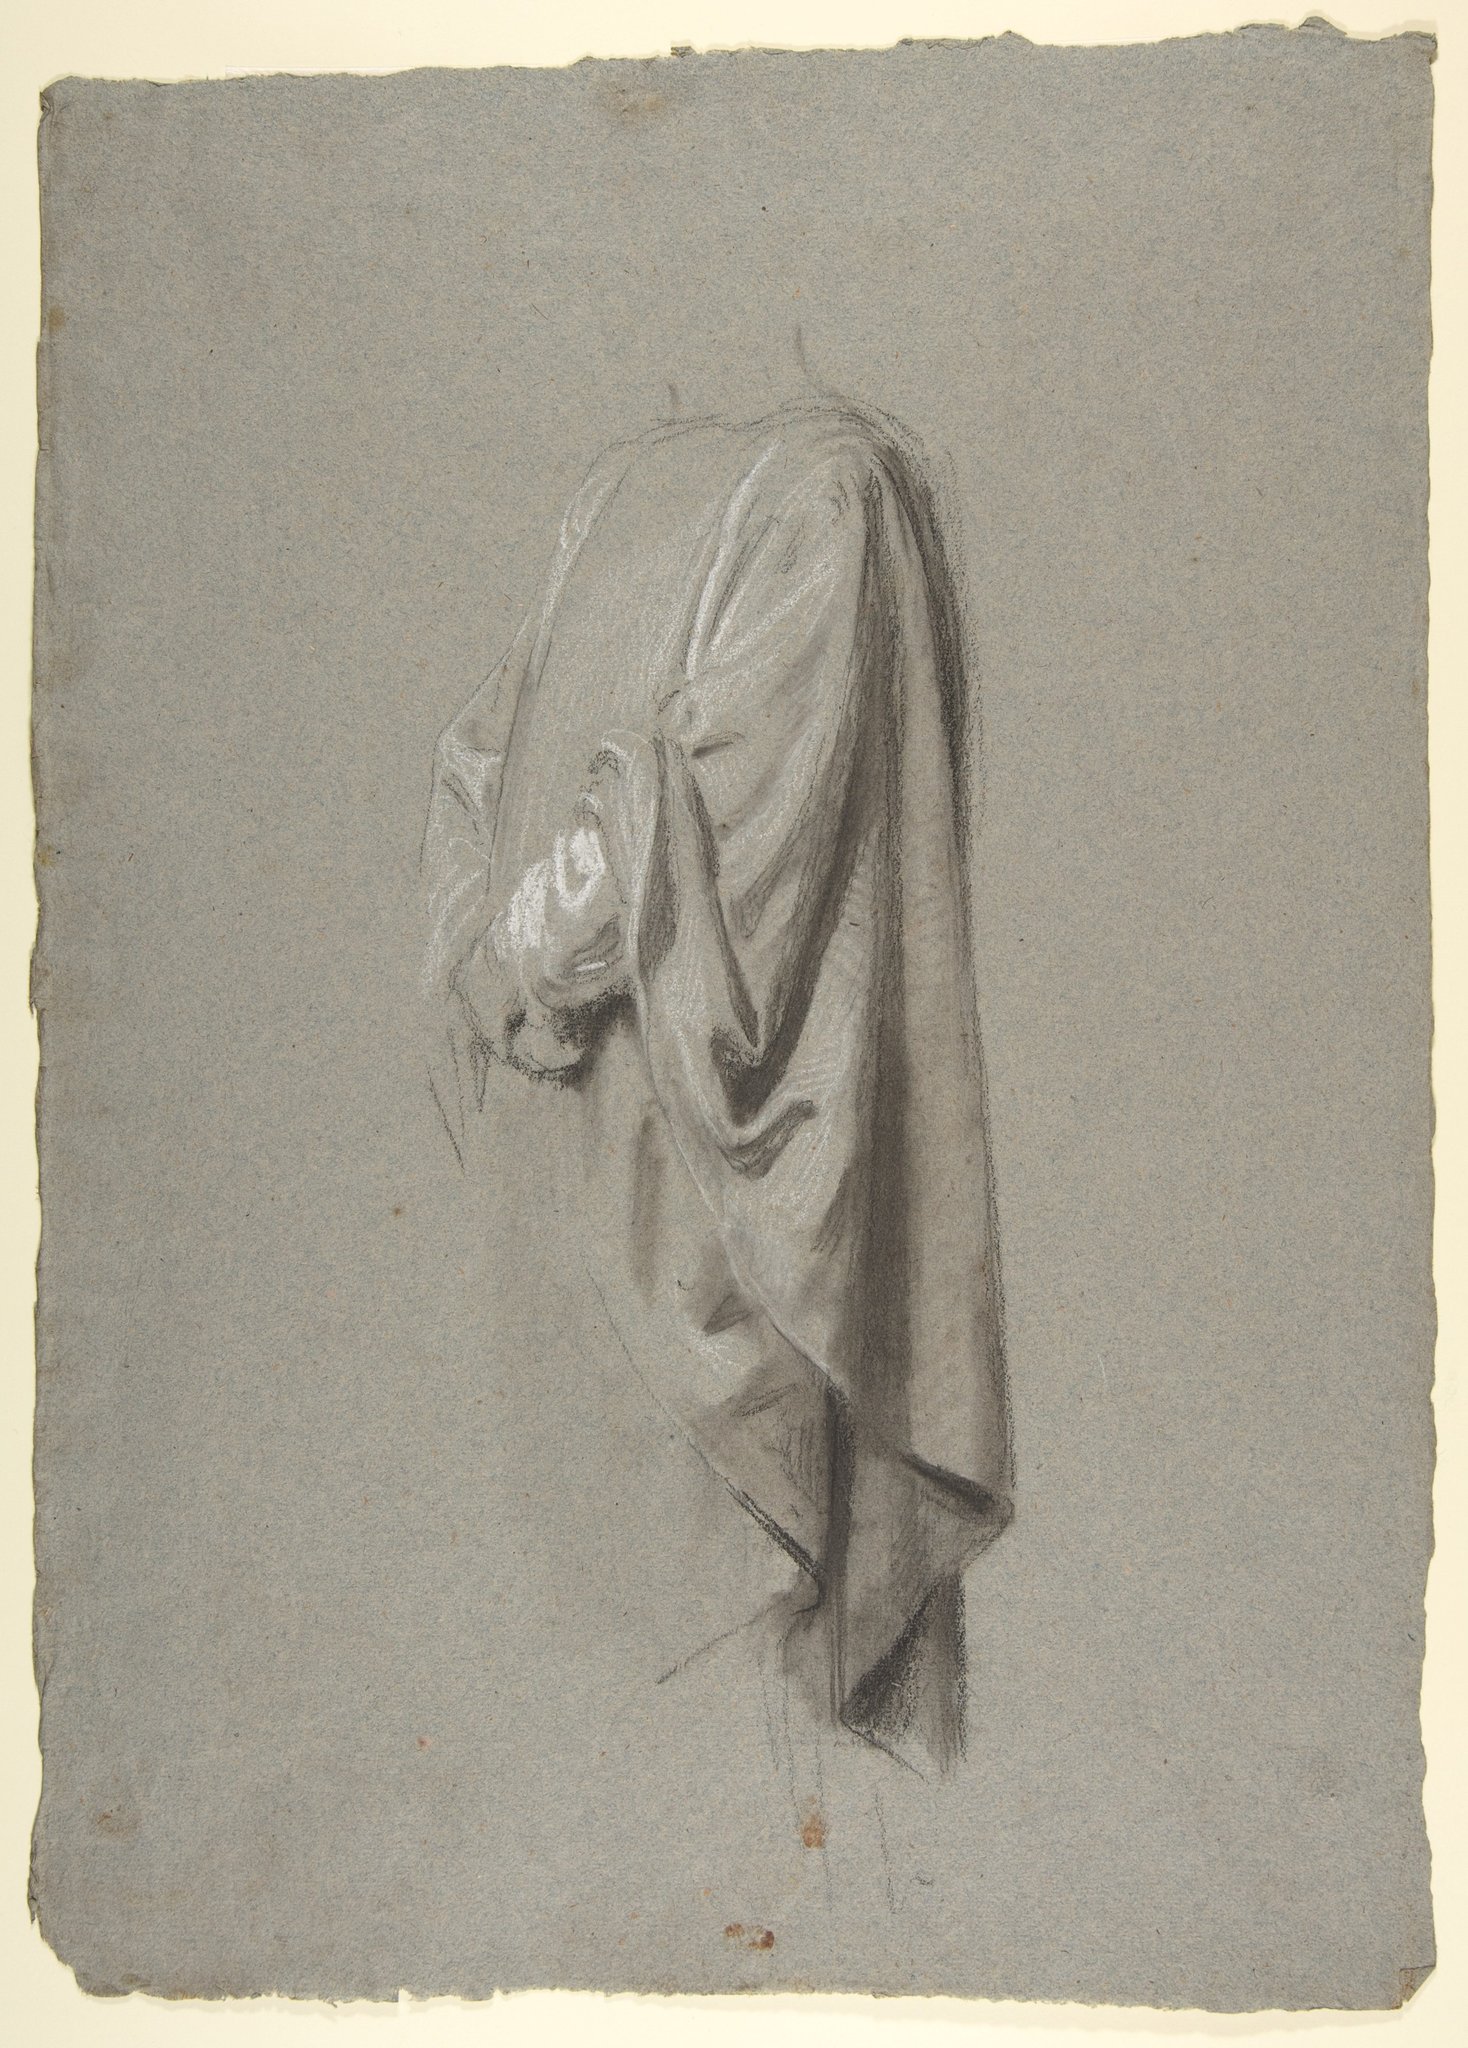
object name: drawing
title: Drapery Study for a Cleric (lower register; study for wall paintings in the Chapel of Saint Remi, Sainte-Clotilde, Paris, 1858)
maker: isidore pils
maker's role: artist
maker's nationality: french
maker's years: 1813-1875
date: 1801-1900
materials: chalk, paper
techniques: heightening, stumping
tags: men